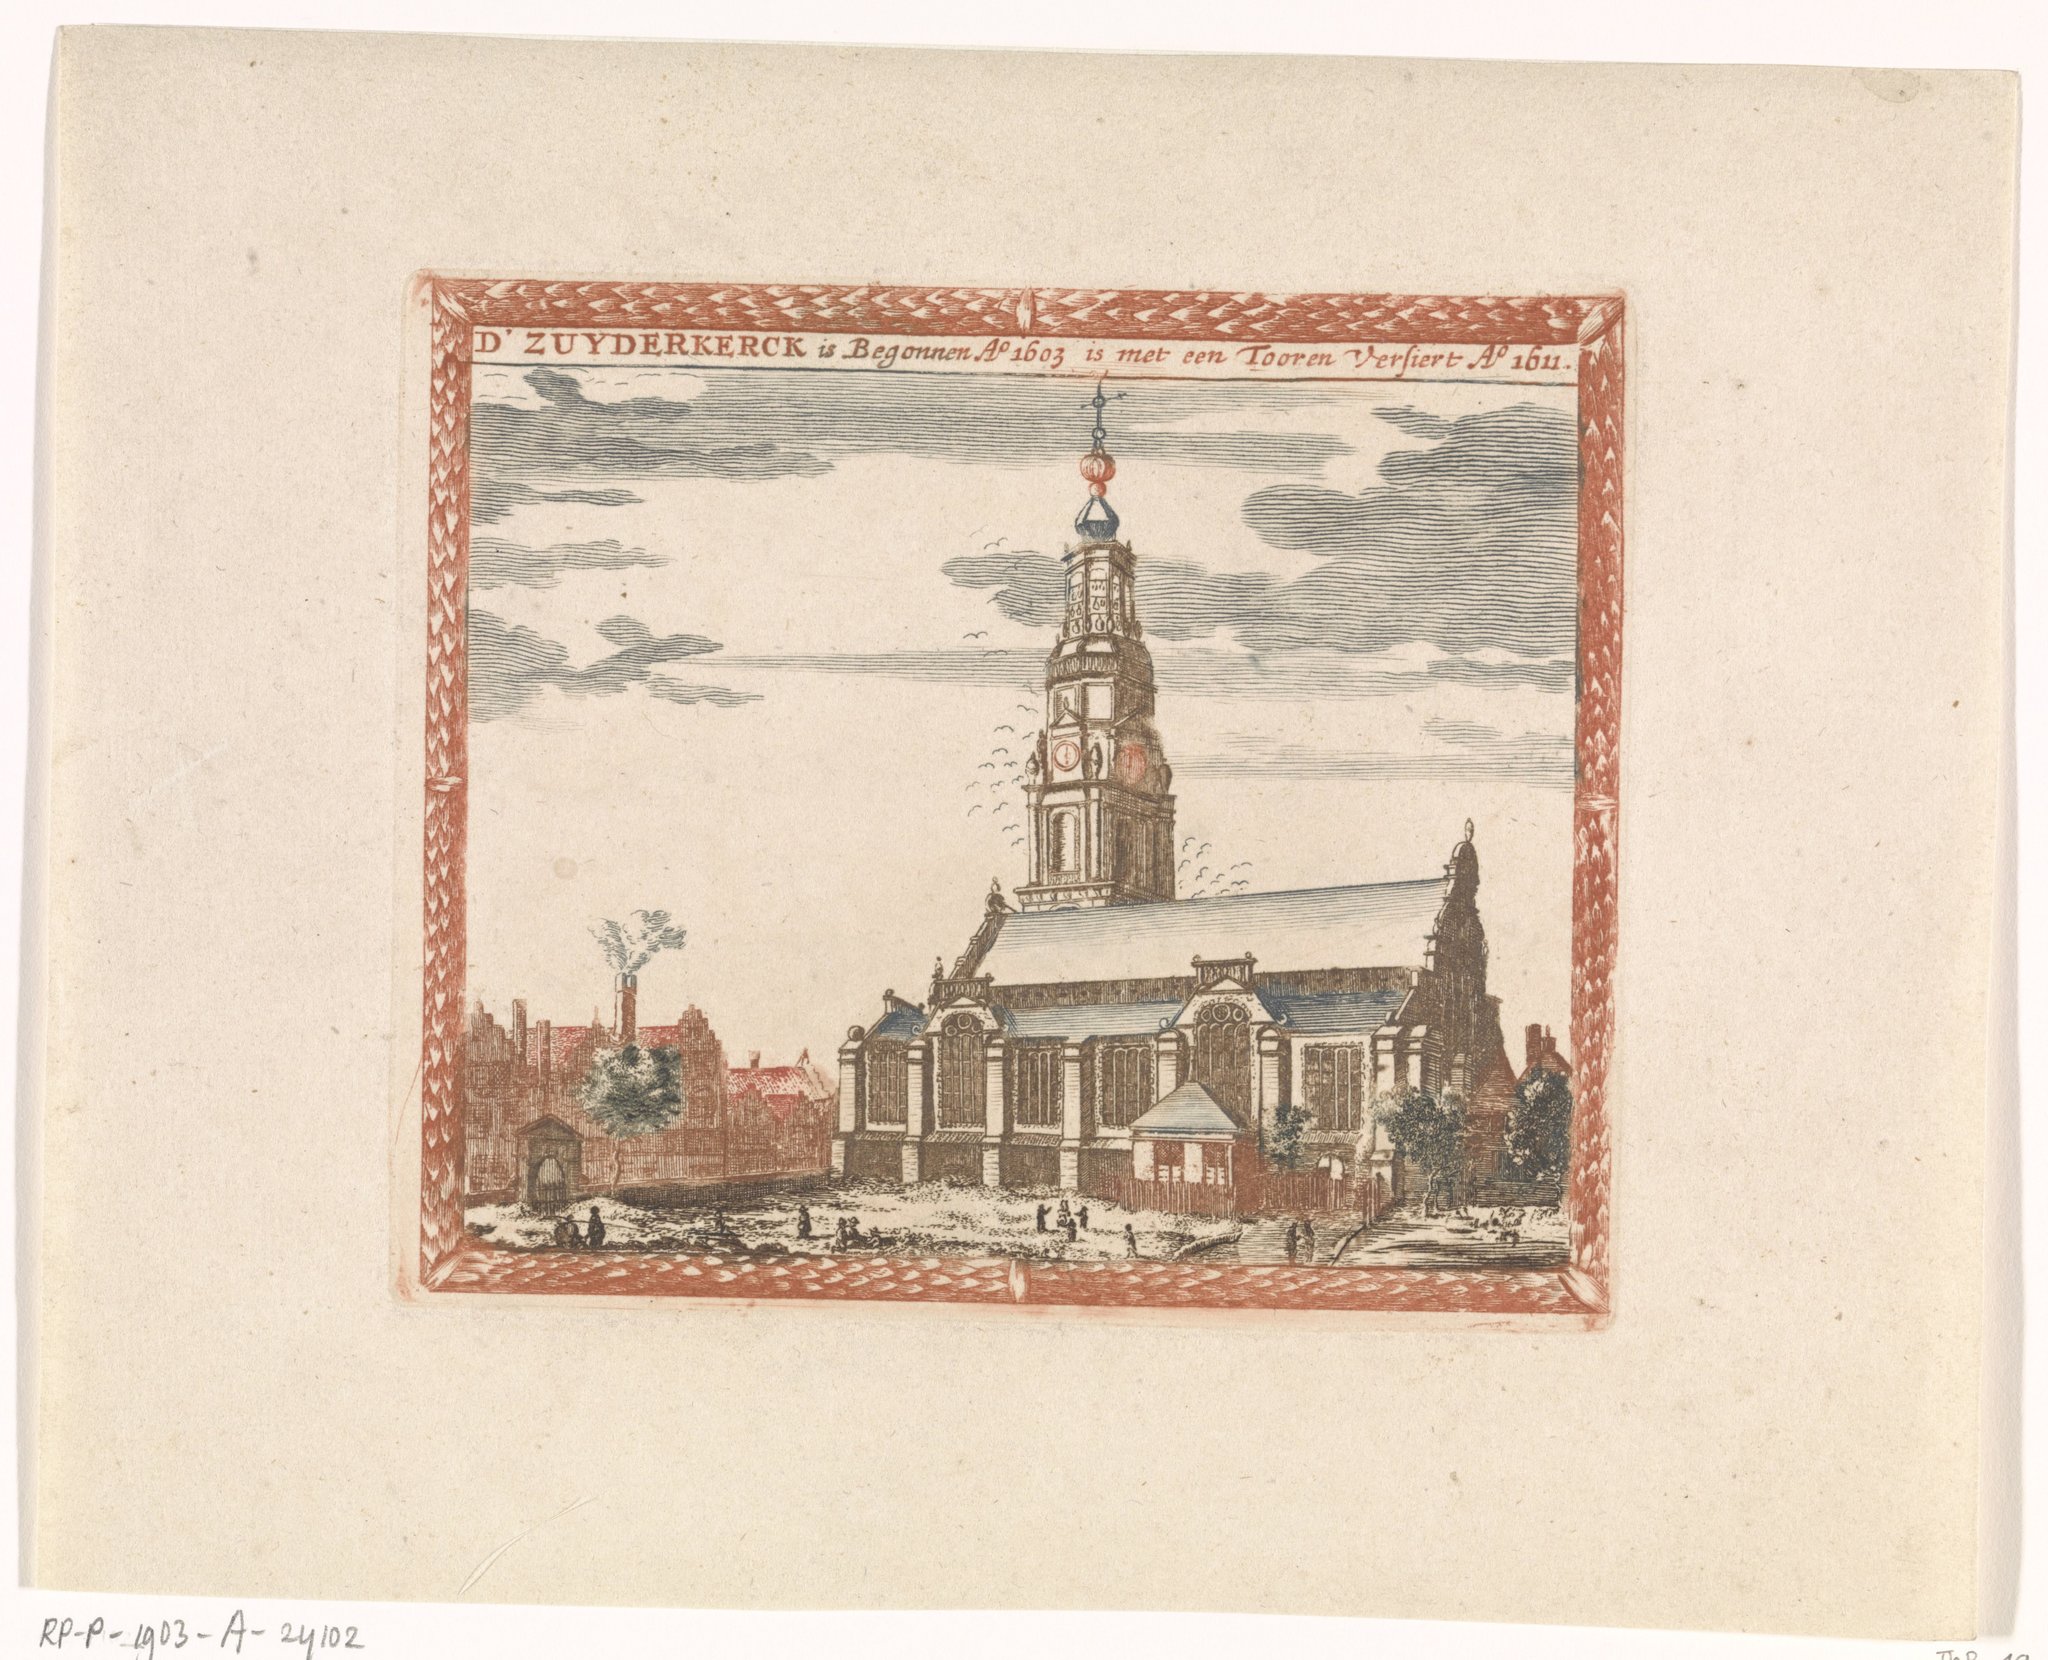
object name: print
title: Zuiderkerk te Amsterdam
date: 1695-1699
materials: paper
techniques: engraving, etching, lithography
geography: amsterdam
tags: church (exterior)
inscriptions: collector's mark: Lugt 2228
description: Prent ook gebruikt in: Tooneel der voornaamste Nederlandse huizen en lusthoven, naar 't leven afgebeeld in 55. kopere plaaten. Amsterdam: Carel Allard, [1697].